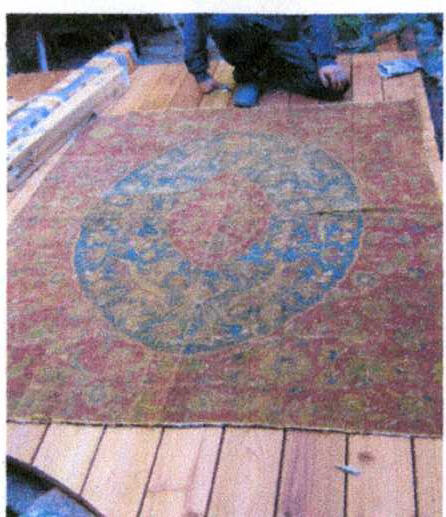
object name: carpet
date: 1501-1700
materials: wool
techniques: asymmetrically knotted pile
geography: egypt